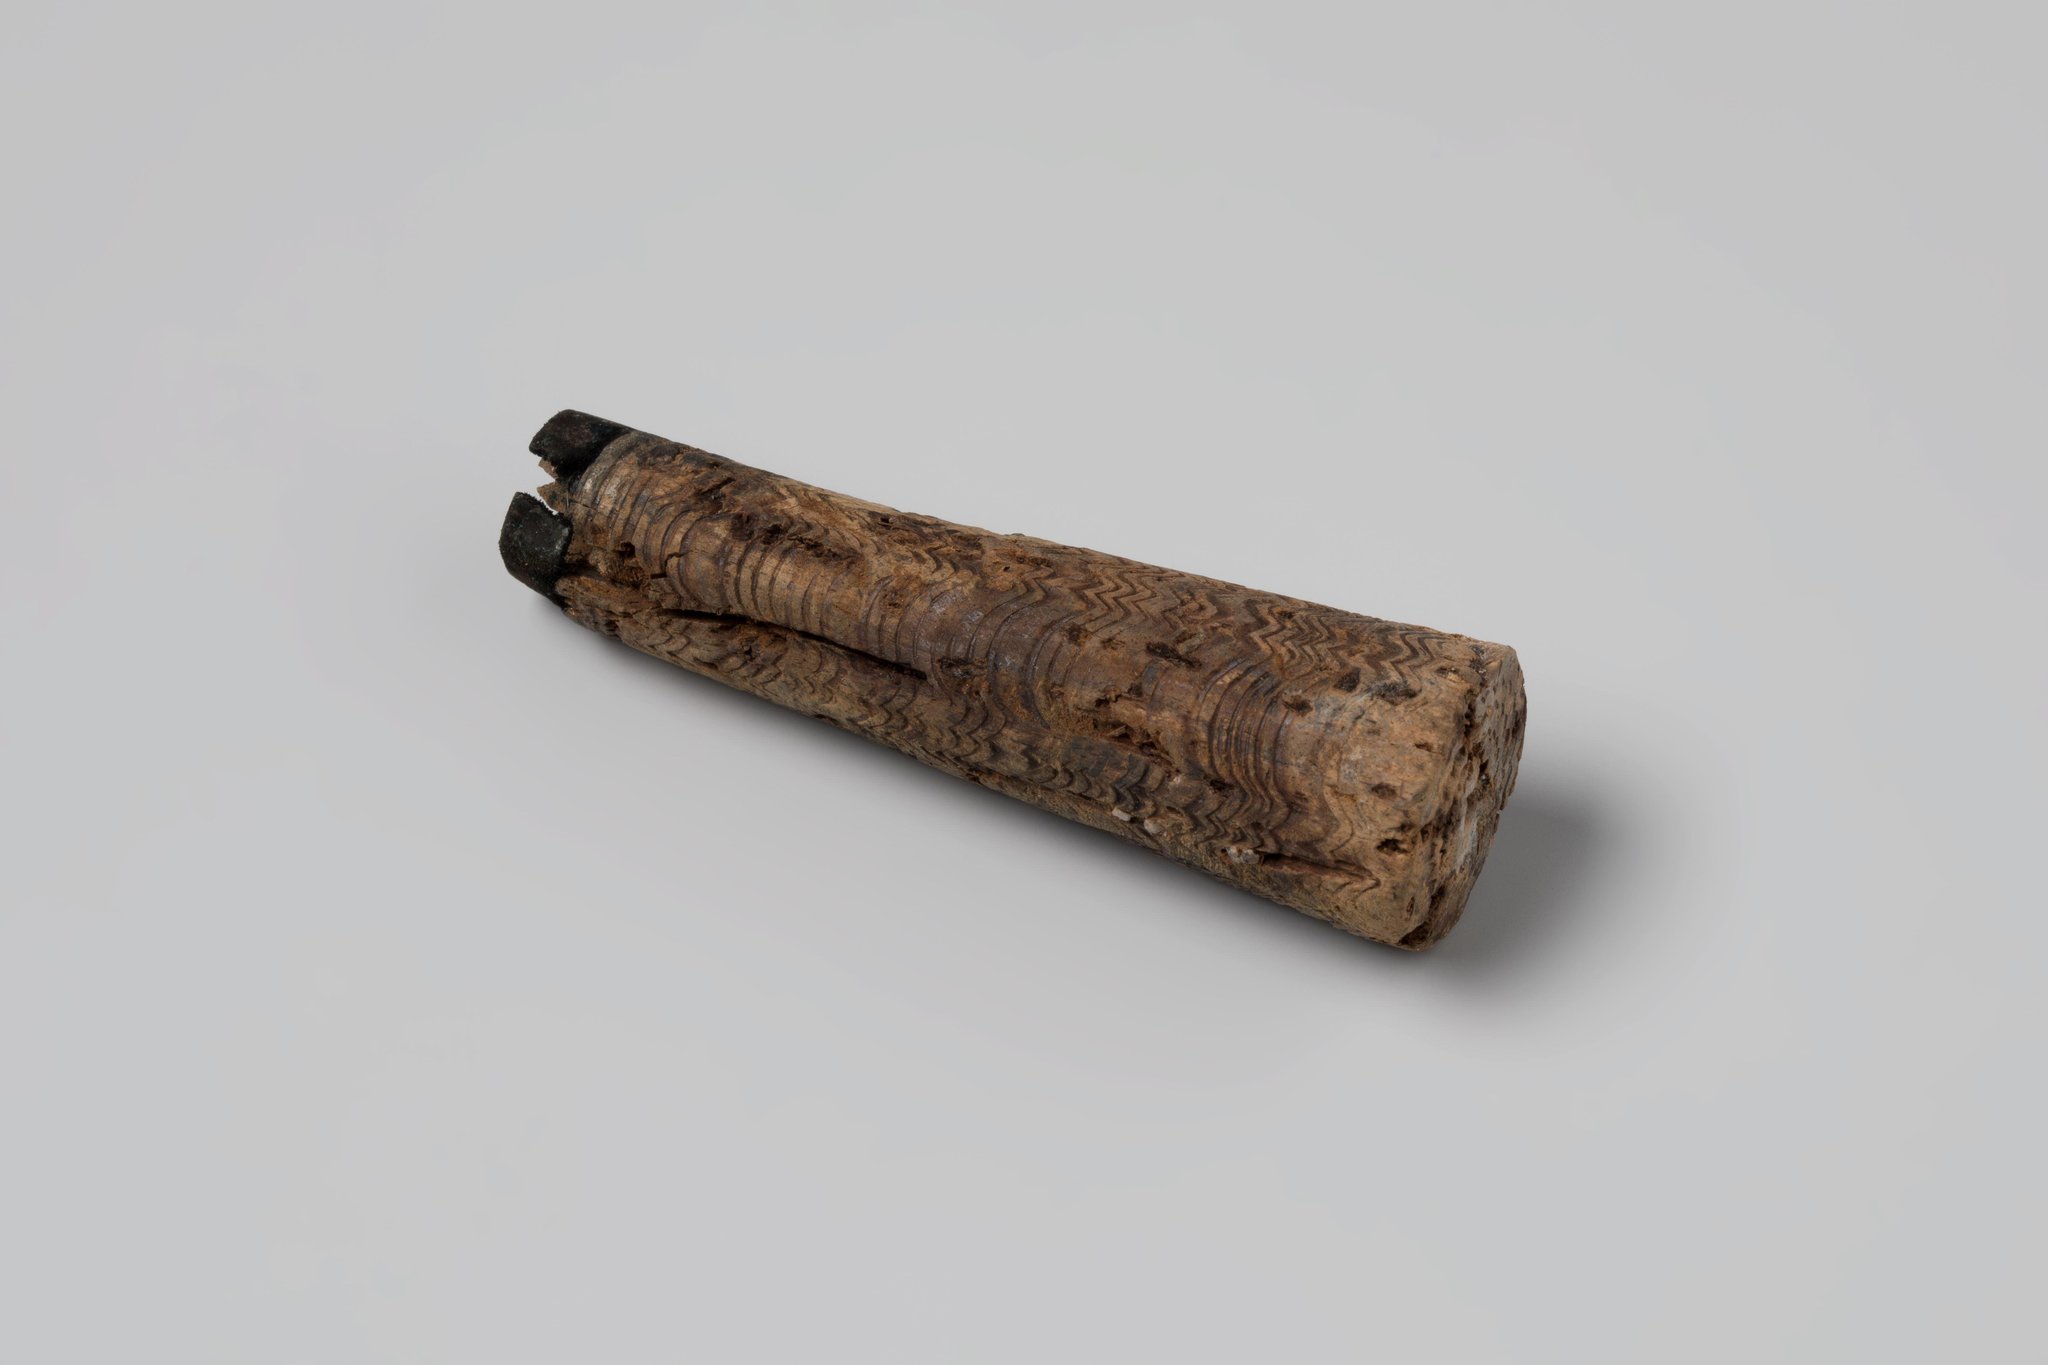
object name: knife handle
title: Messenheft uit het wrak van de Oost-Indiëvaarder Hollandia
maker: Anonymous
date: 1700-1743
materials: metal, wood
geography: netherlands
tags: verenigde oostindische compagnie, hollandia (schip), annet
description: Knife, handle, cylindrical: tapering; id. NG 1980-27H512a.